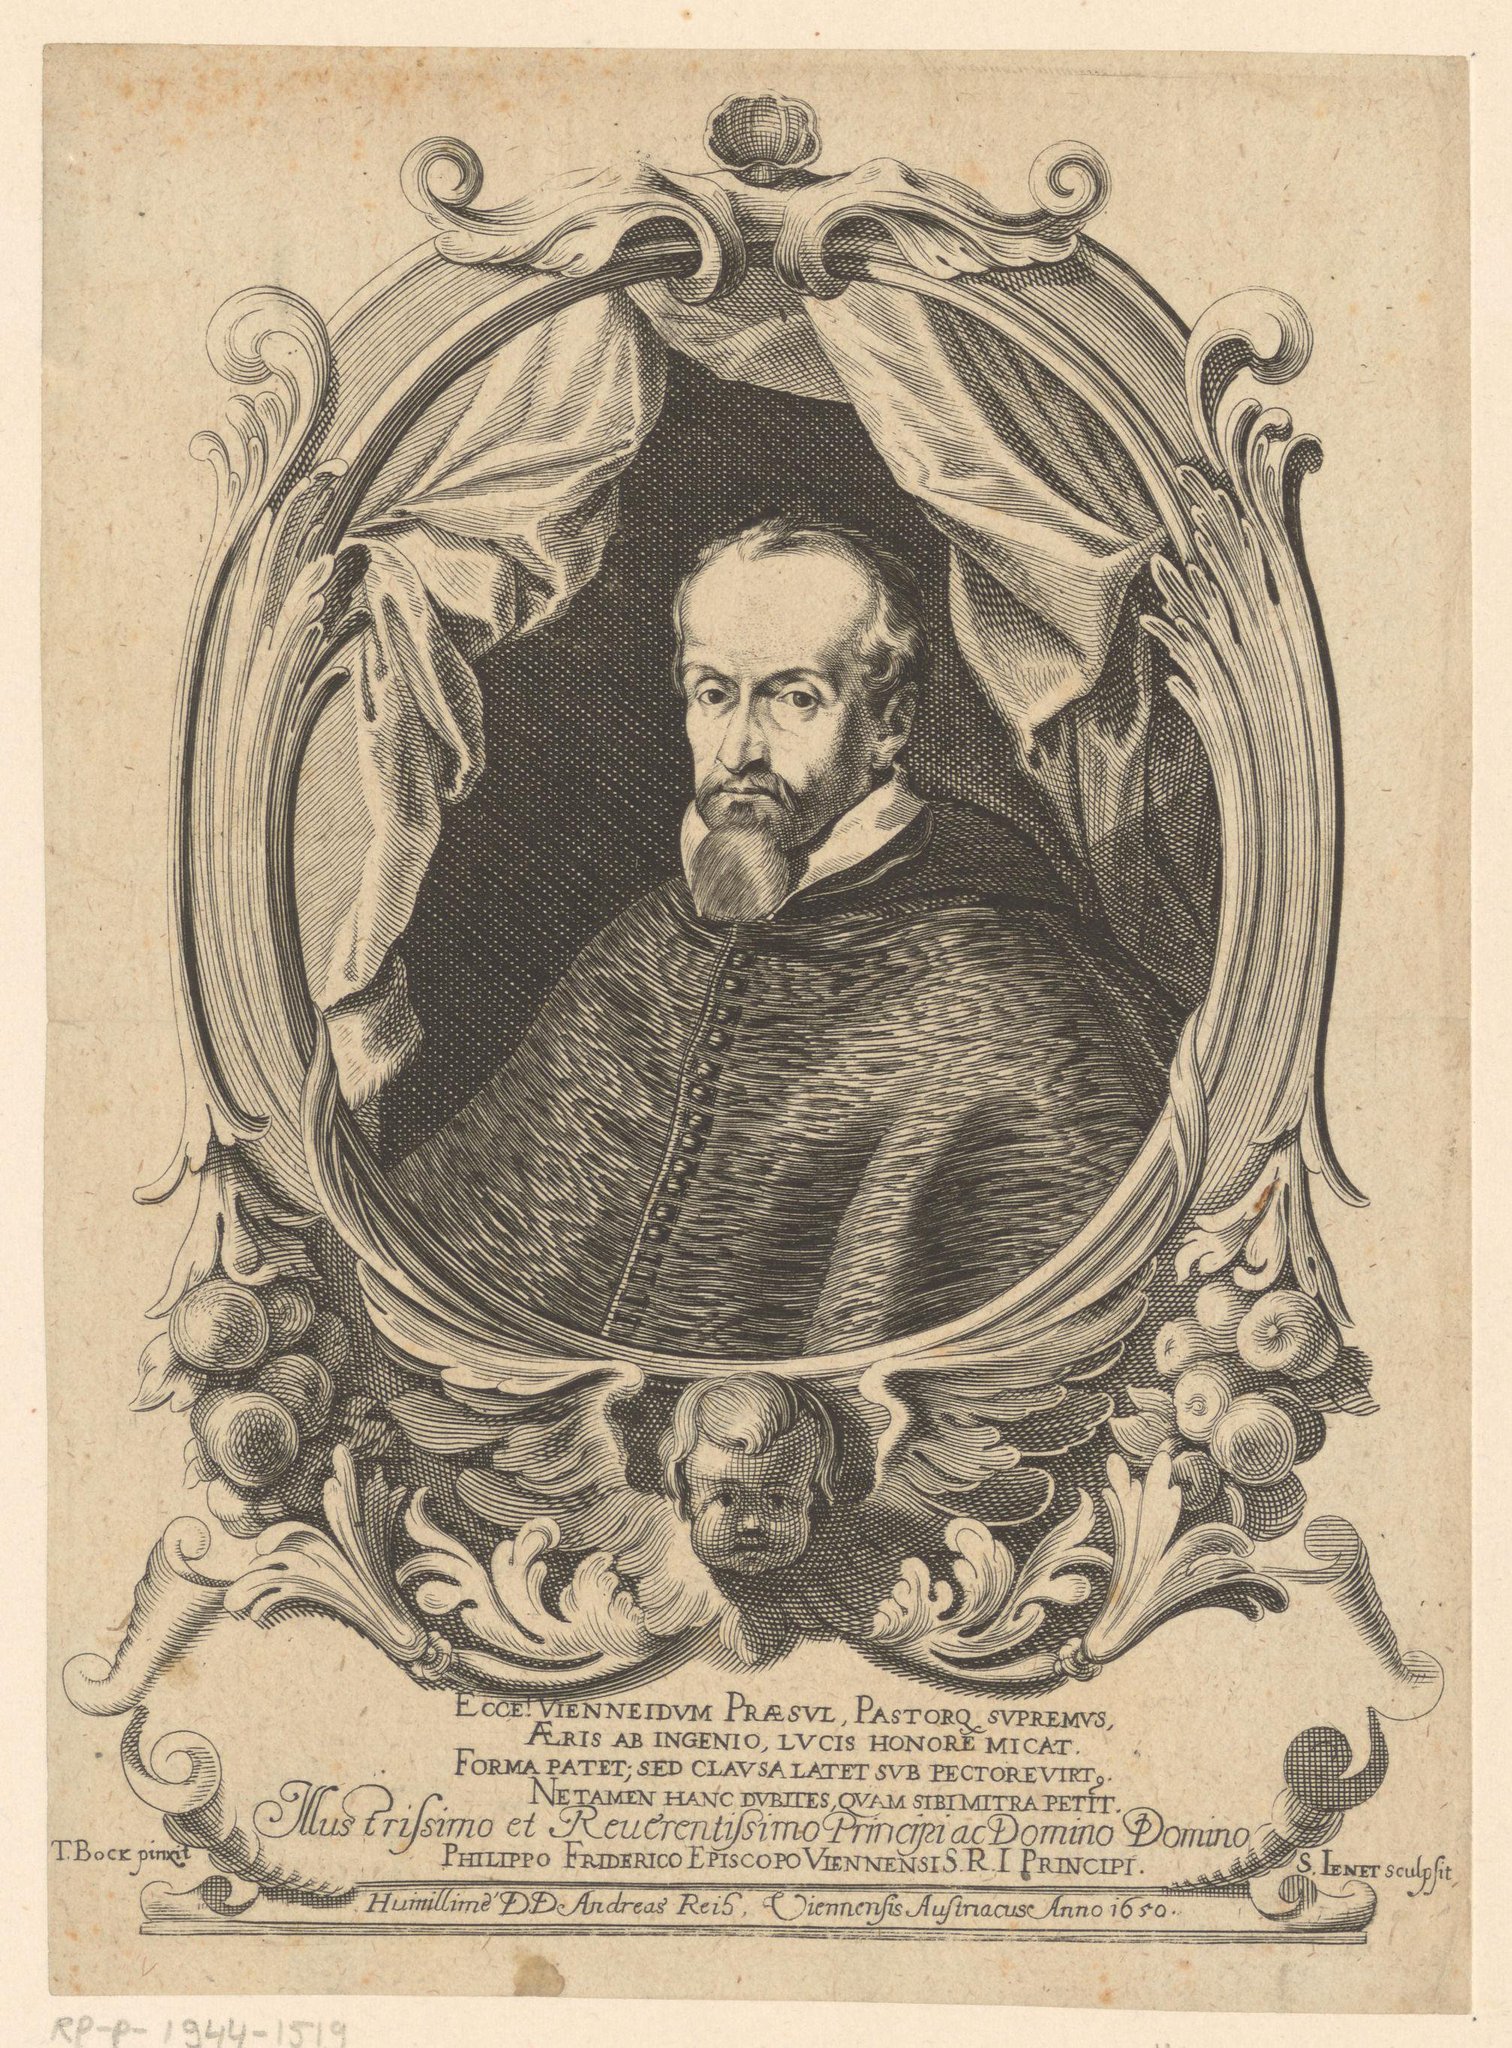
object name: print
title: Portret van Philipp Friedrich Breuner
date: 1650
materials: paper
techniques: engraving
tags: theologian, historical persons, ornament ~ cartouche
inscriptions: collector's mark: Lugt 845, collector's mark: Lugt 2228